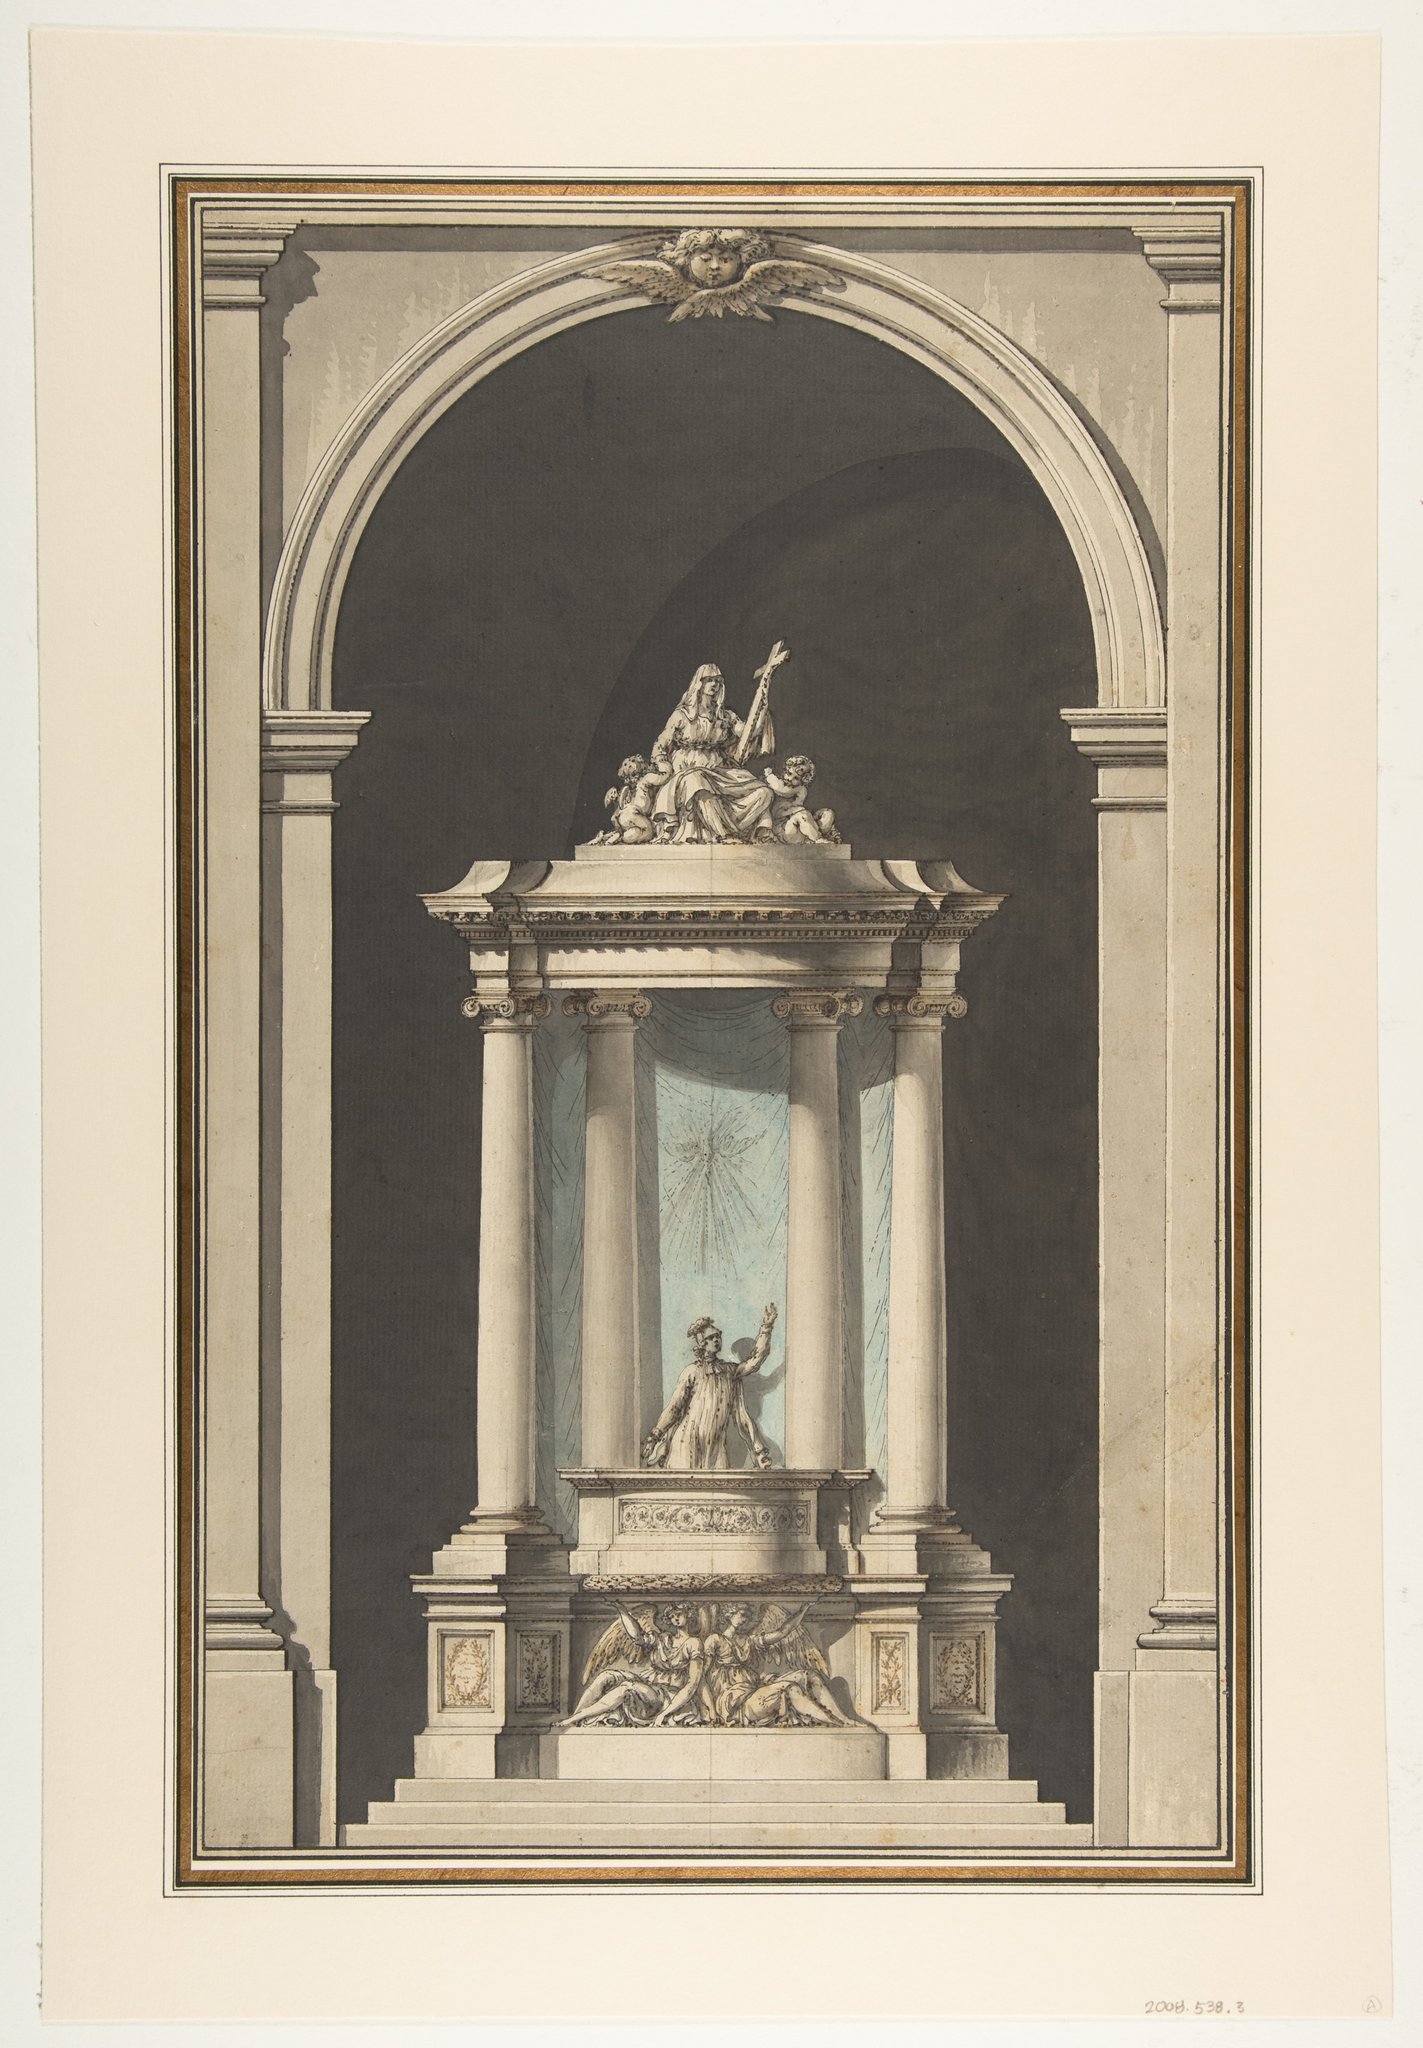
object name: drawing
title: Design for a Pulpit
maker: louis gustave taraval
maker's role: artist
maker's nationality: french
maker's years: 1738-1794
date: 1701-1800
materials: chalk, ink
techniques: brush, pen, wash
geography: france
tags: architecture,columns